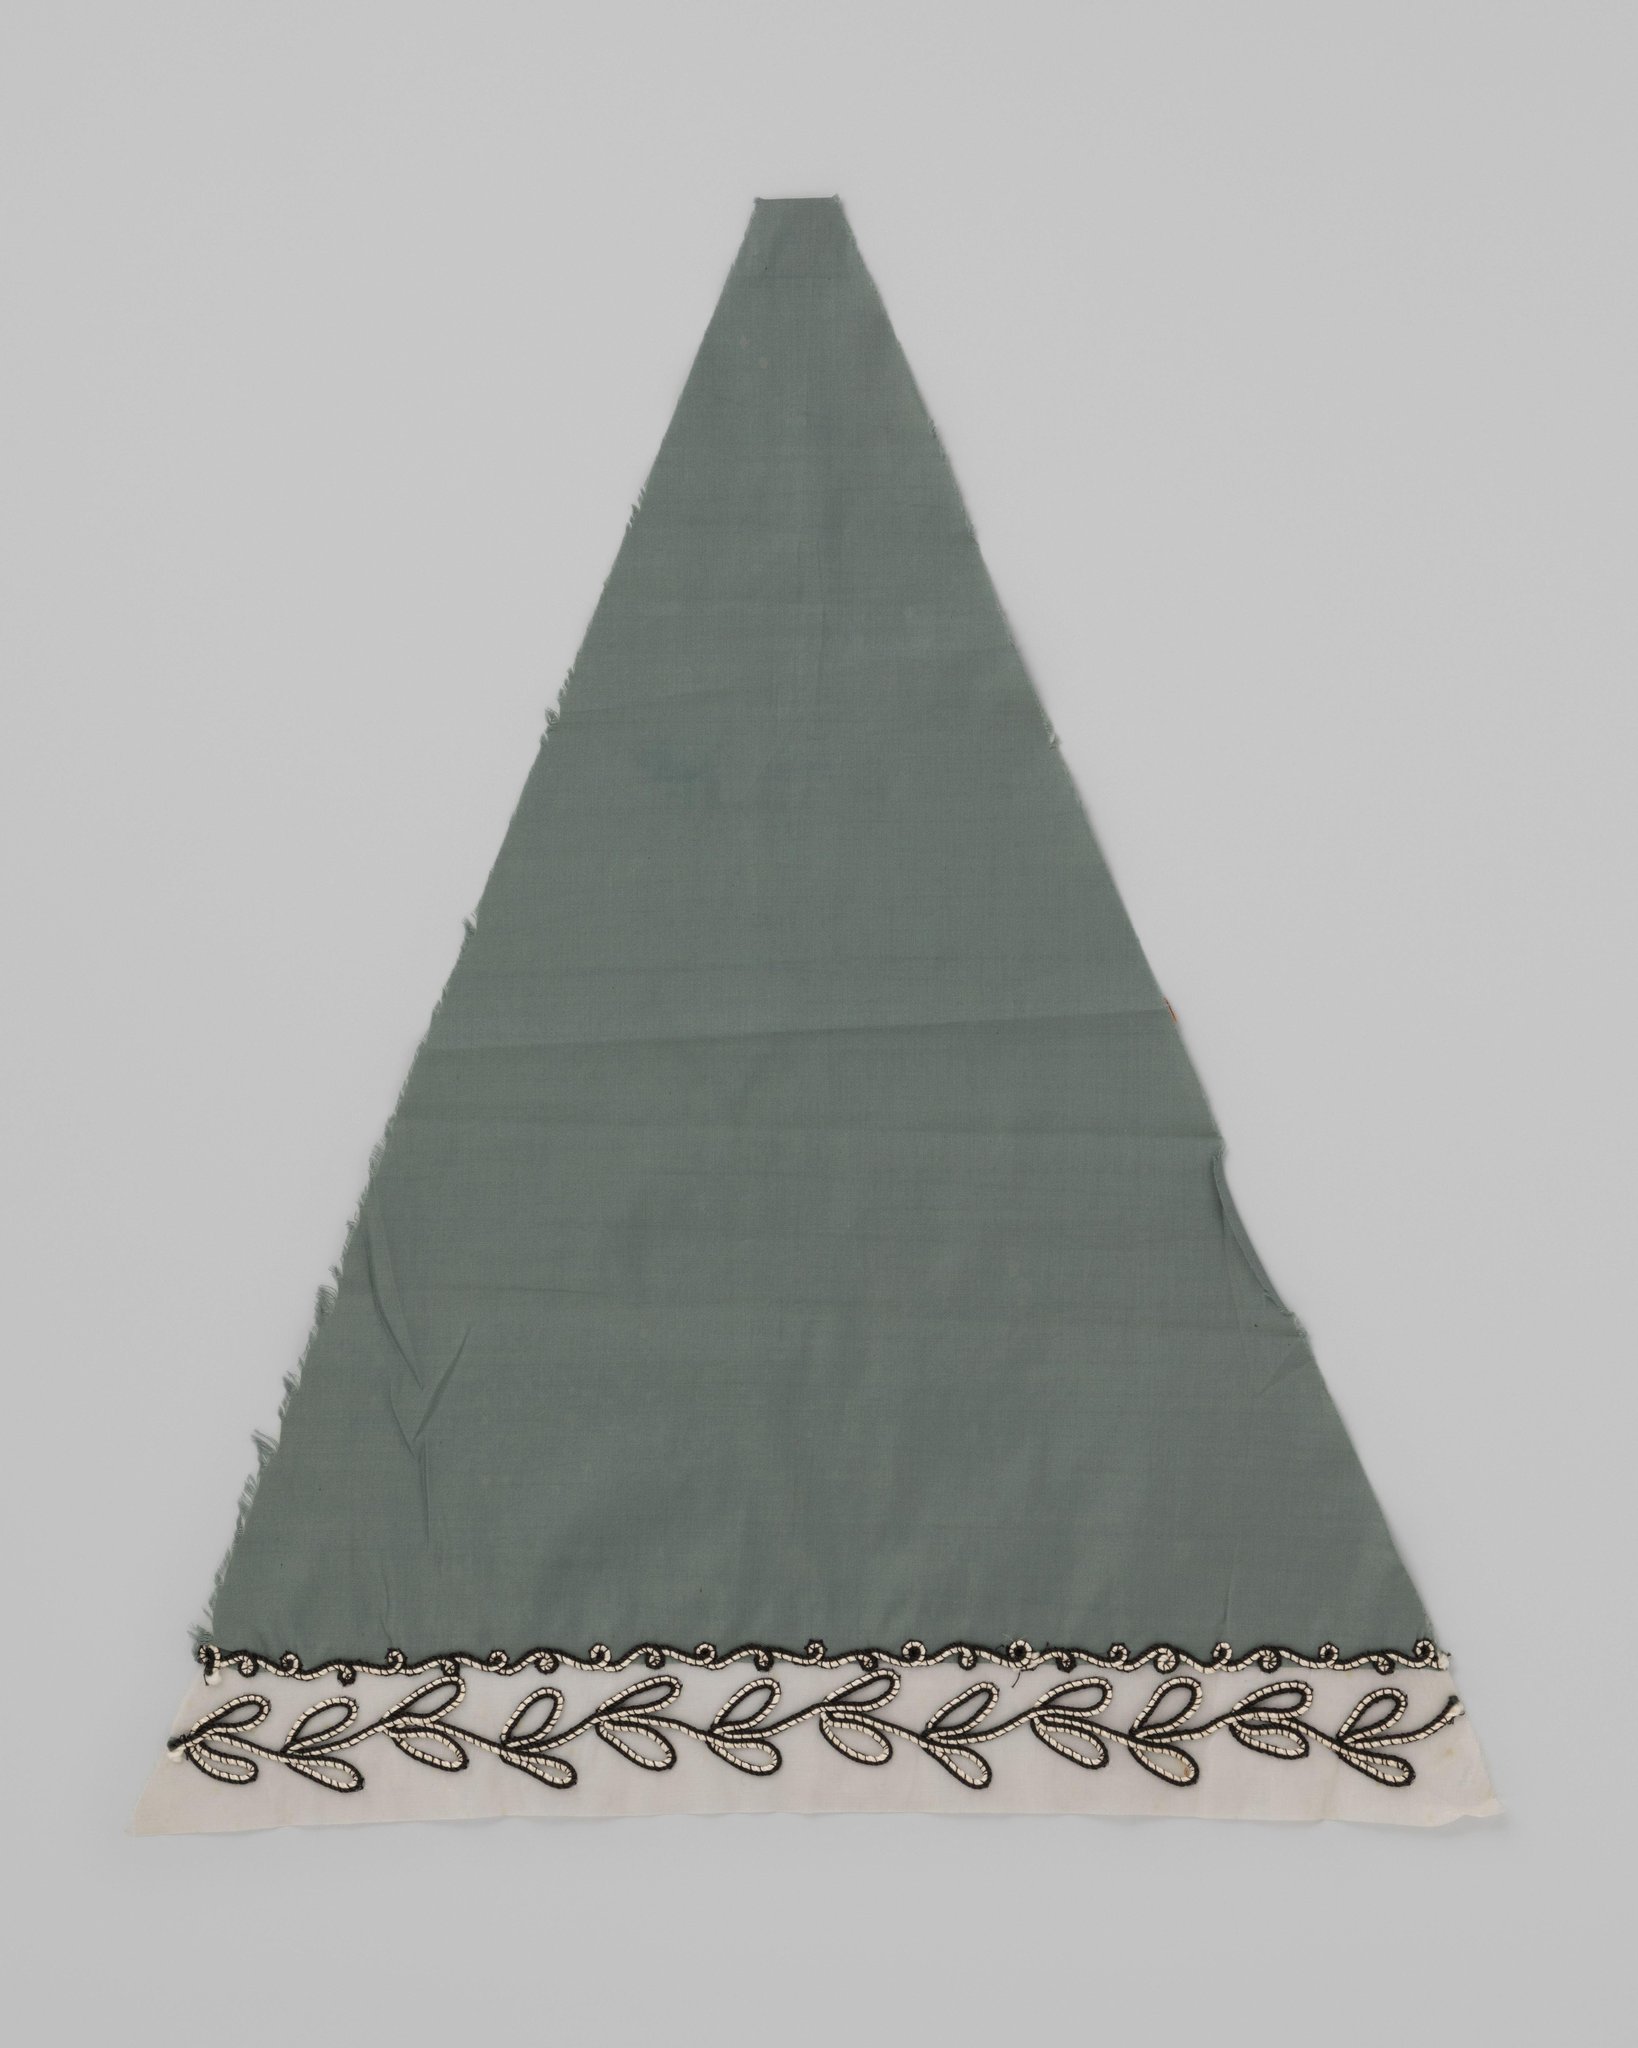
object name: parasoldek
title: Sector van een parasoldek van zachtgroene katoen, met een met woldraad geborduurde batisten rand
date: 1885-1900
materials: cotton, wool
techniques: embroidered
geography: france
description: Sector van een parasoldek van zachtgroene katoen, met een met woldraad geborduurde batisten rand.